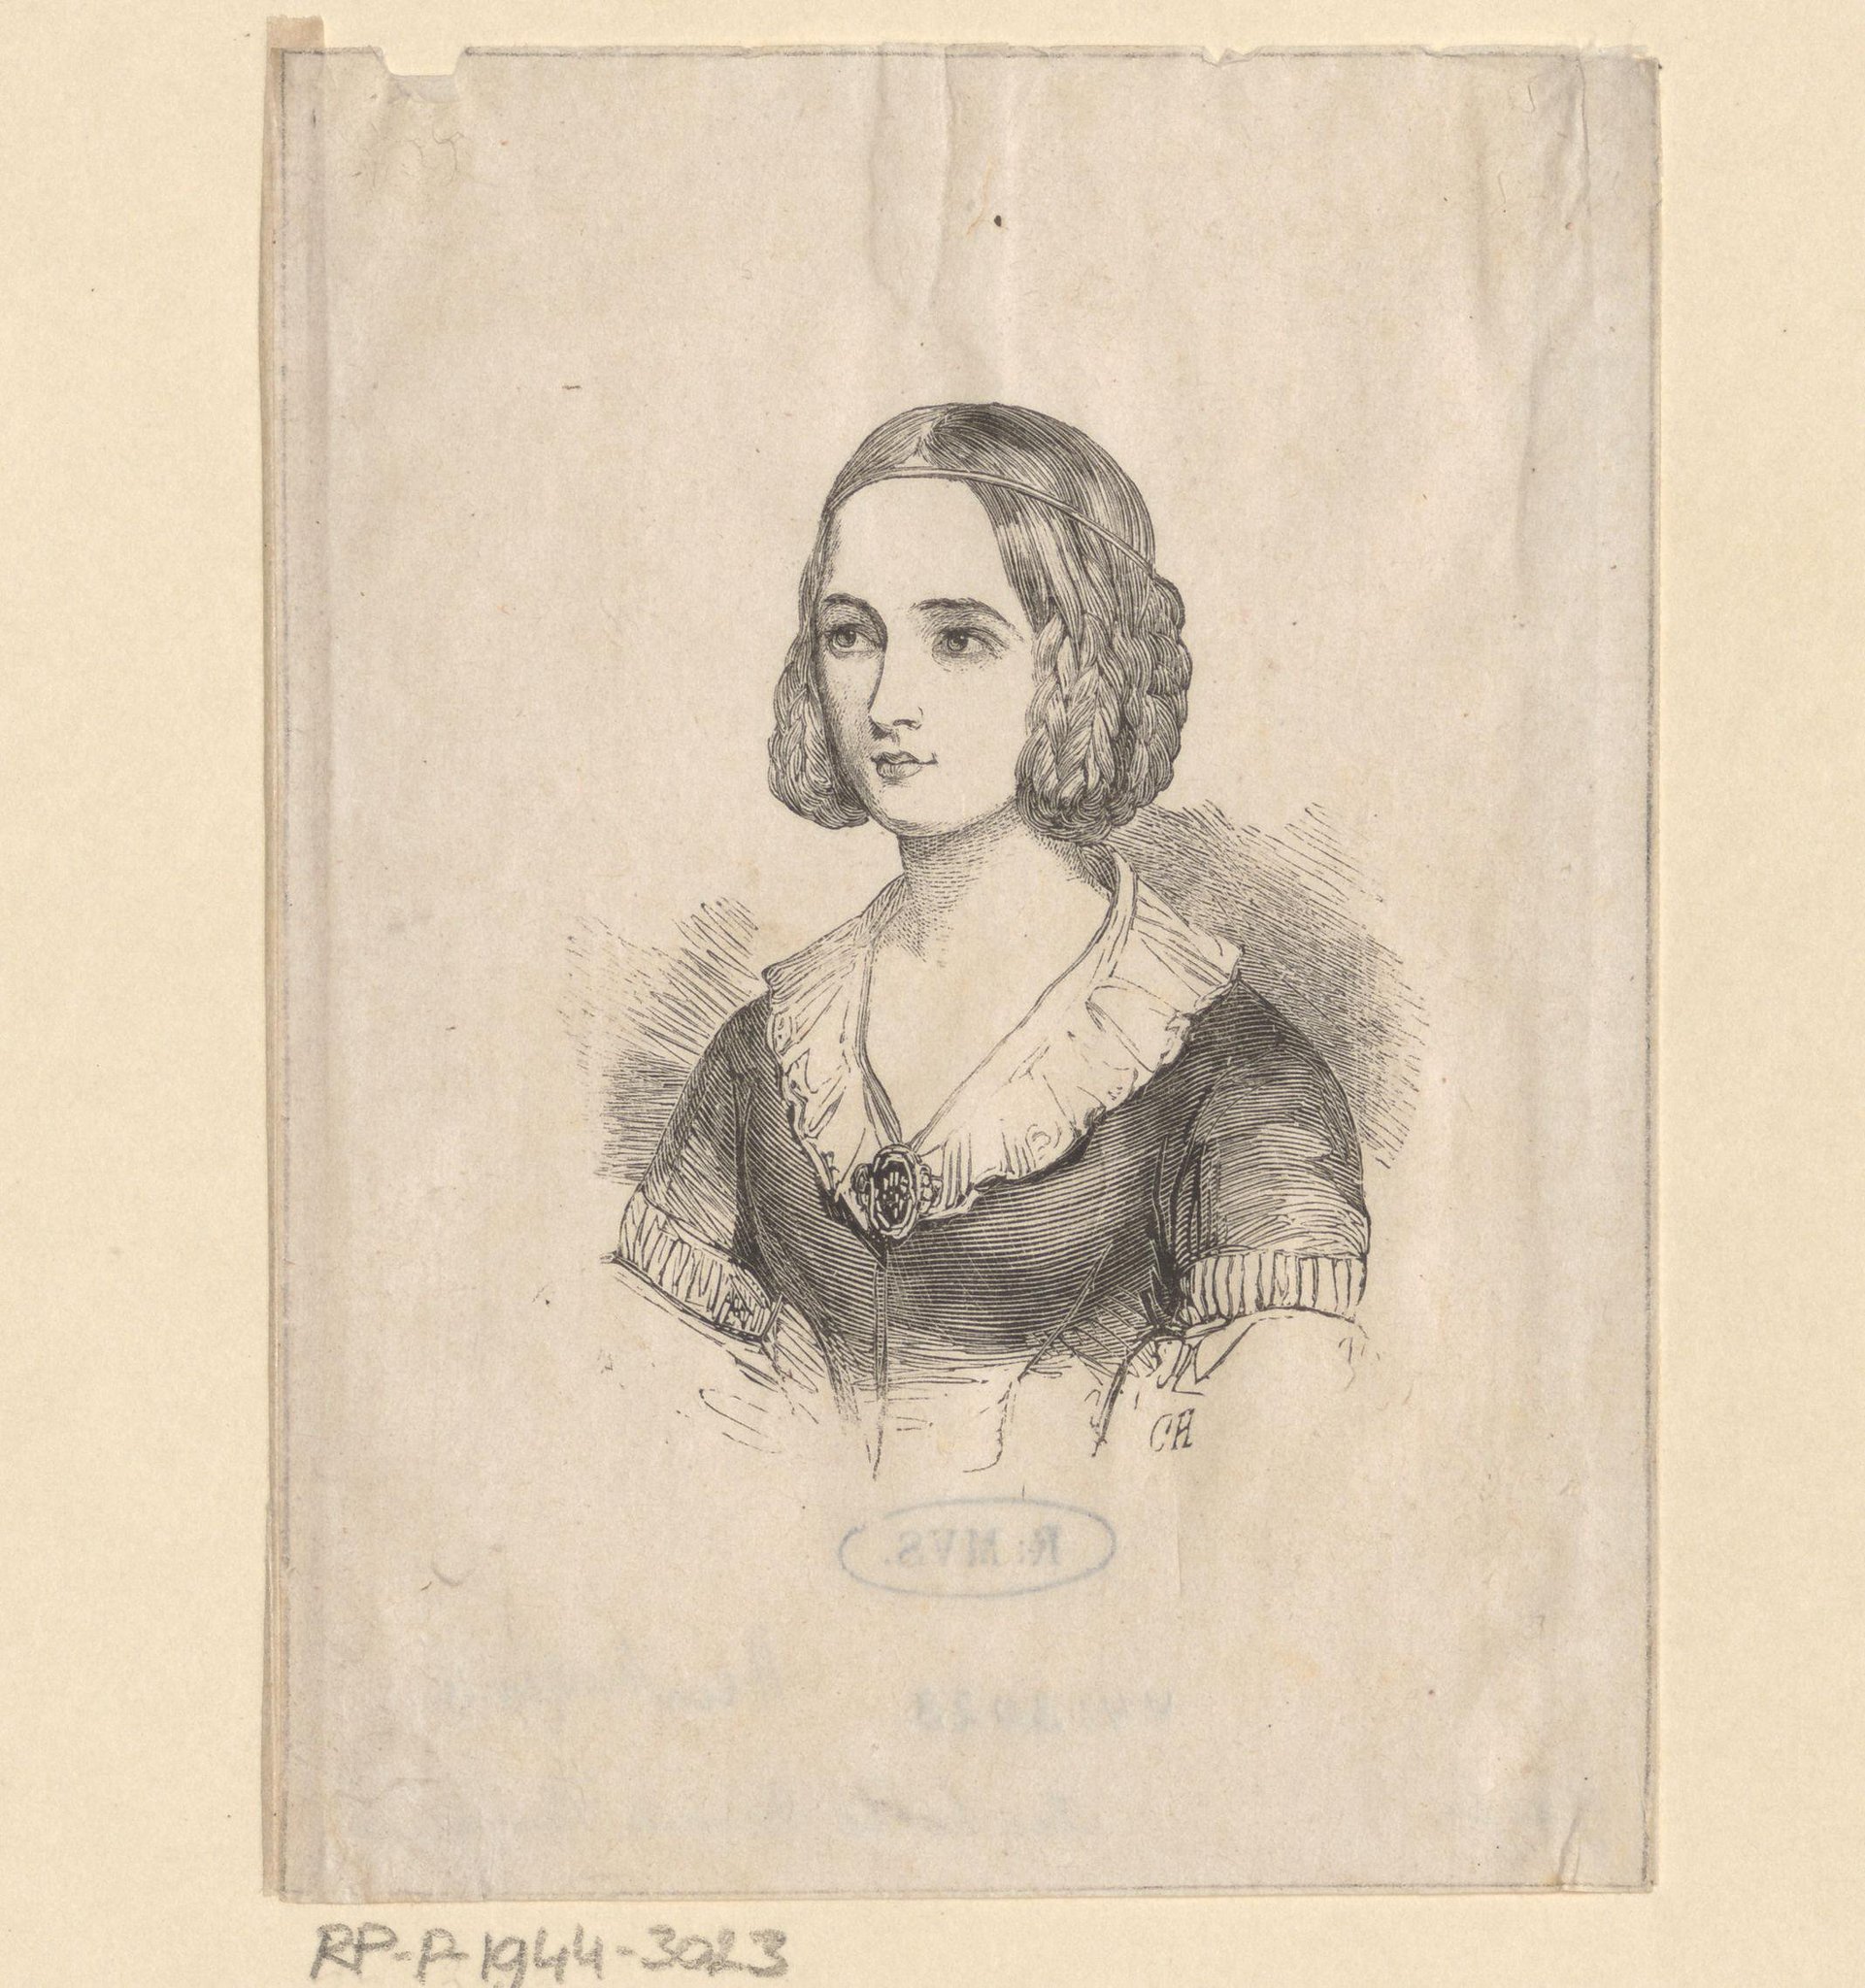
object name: print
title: Portret van Fanny Geefs-Corr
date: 1842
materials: paper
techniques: engraving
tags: brussels, painter, print maker, draughtsman, fanny geefs-corr, historical persons - bb - woman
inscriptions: collector's mark: Lugt 2228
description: Prent met tekst op verso gebruikt in: Immerzeel, Johannes. De levens en werken der Hollandsche en Vlaamsche kunstschilders. Den Haag: Johannes Christoffel van Kesteren, 1842, dl. 1, p. 34.